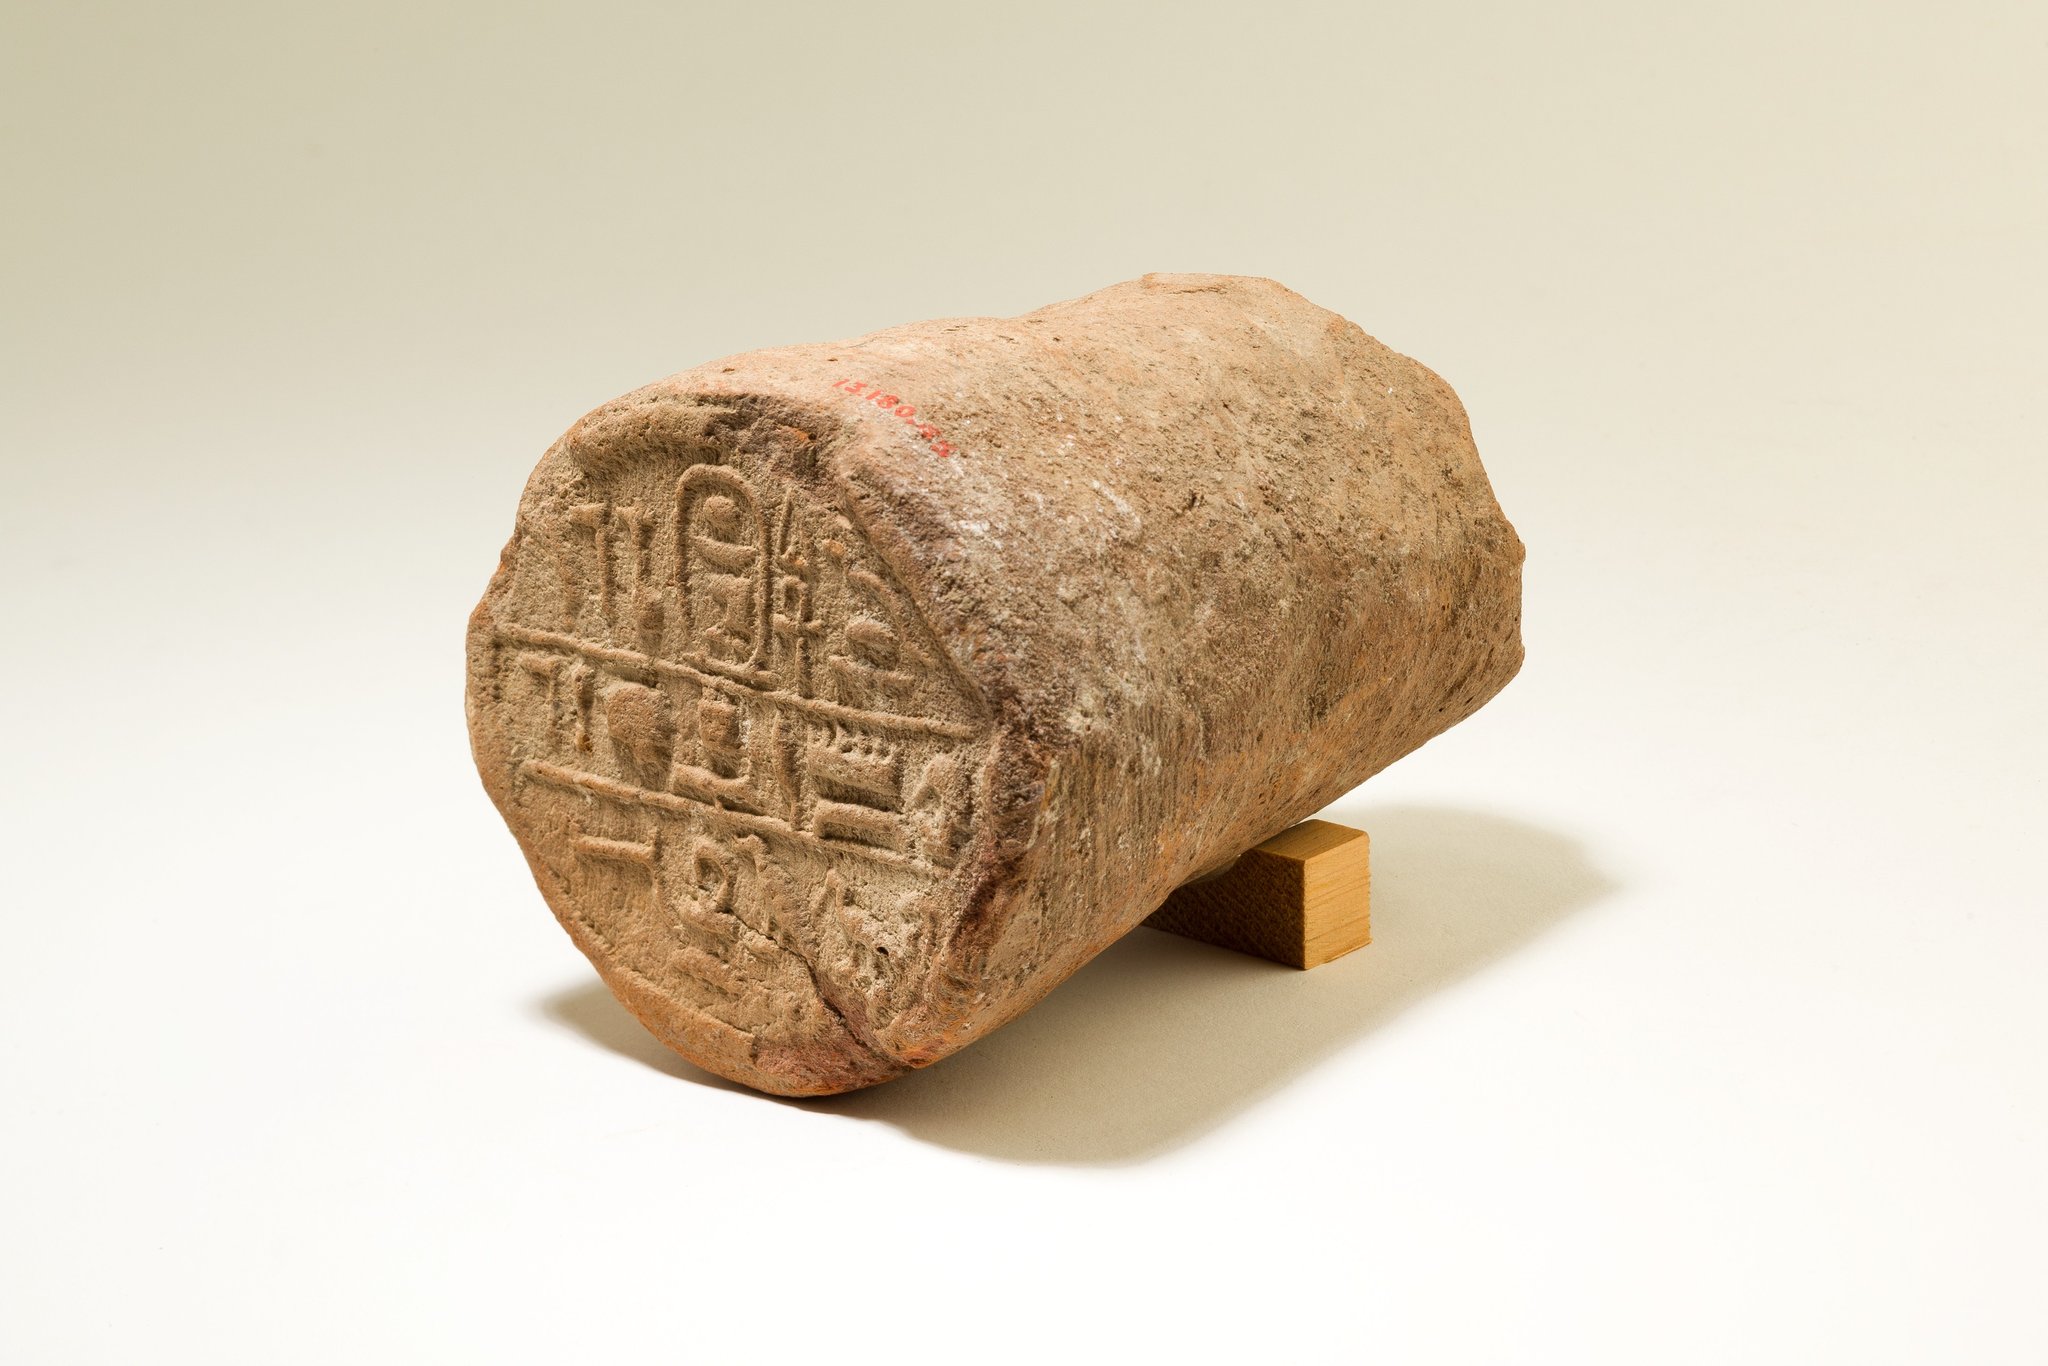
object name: cone, circular impression, djehutynefer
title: Funerary Cone of Djehuty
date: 1550-1525 BCE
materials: pottery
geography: egypt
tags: hieroglyphs